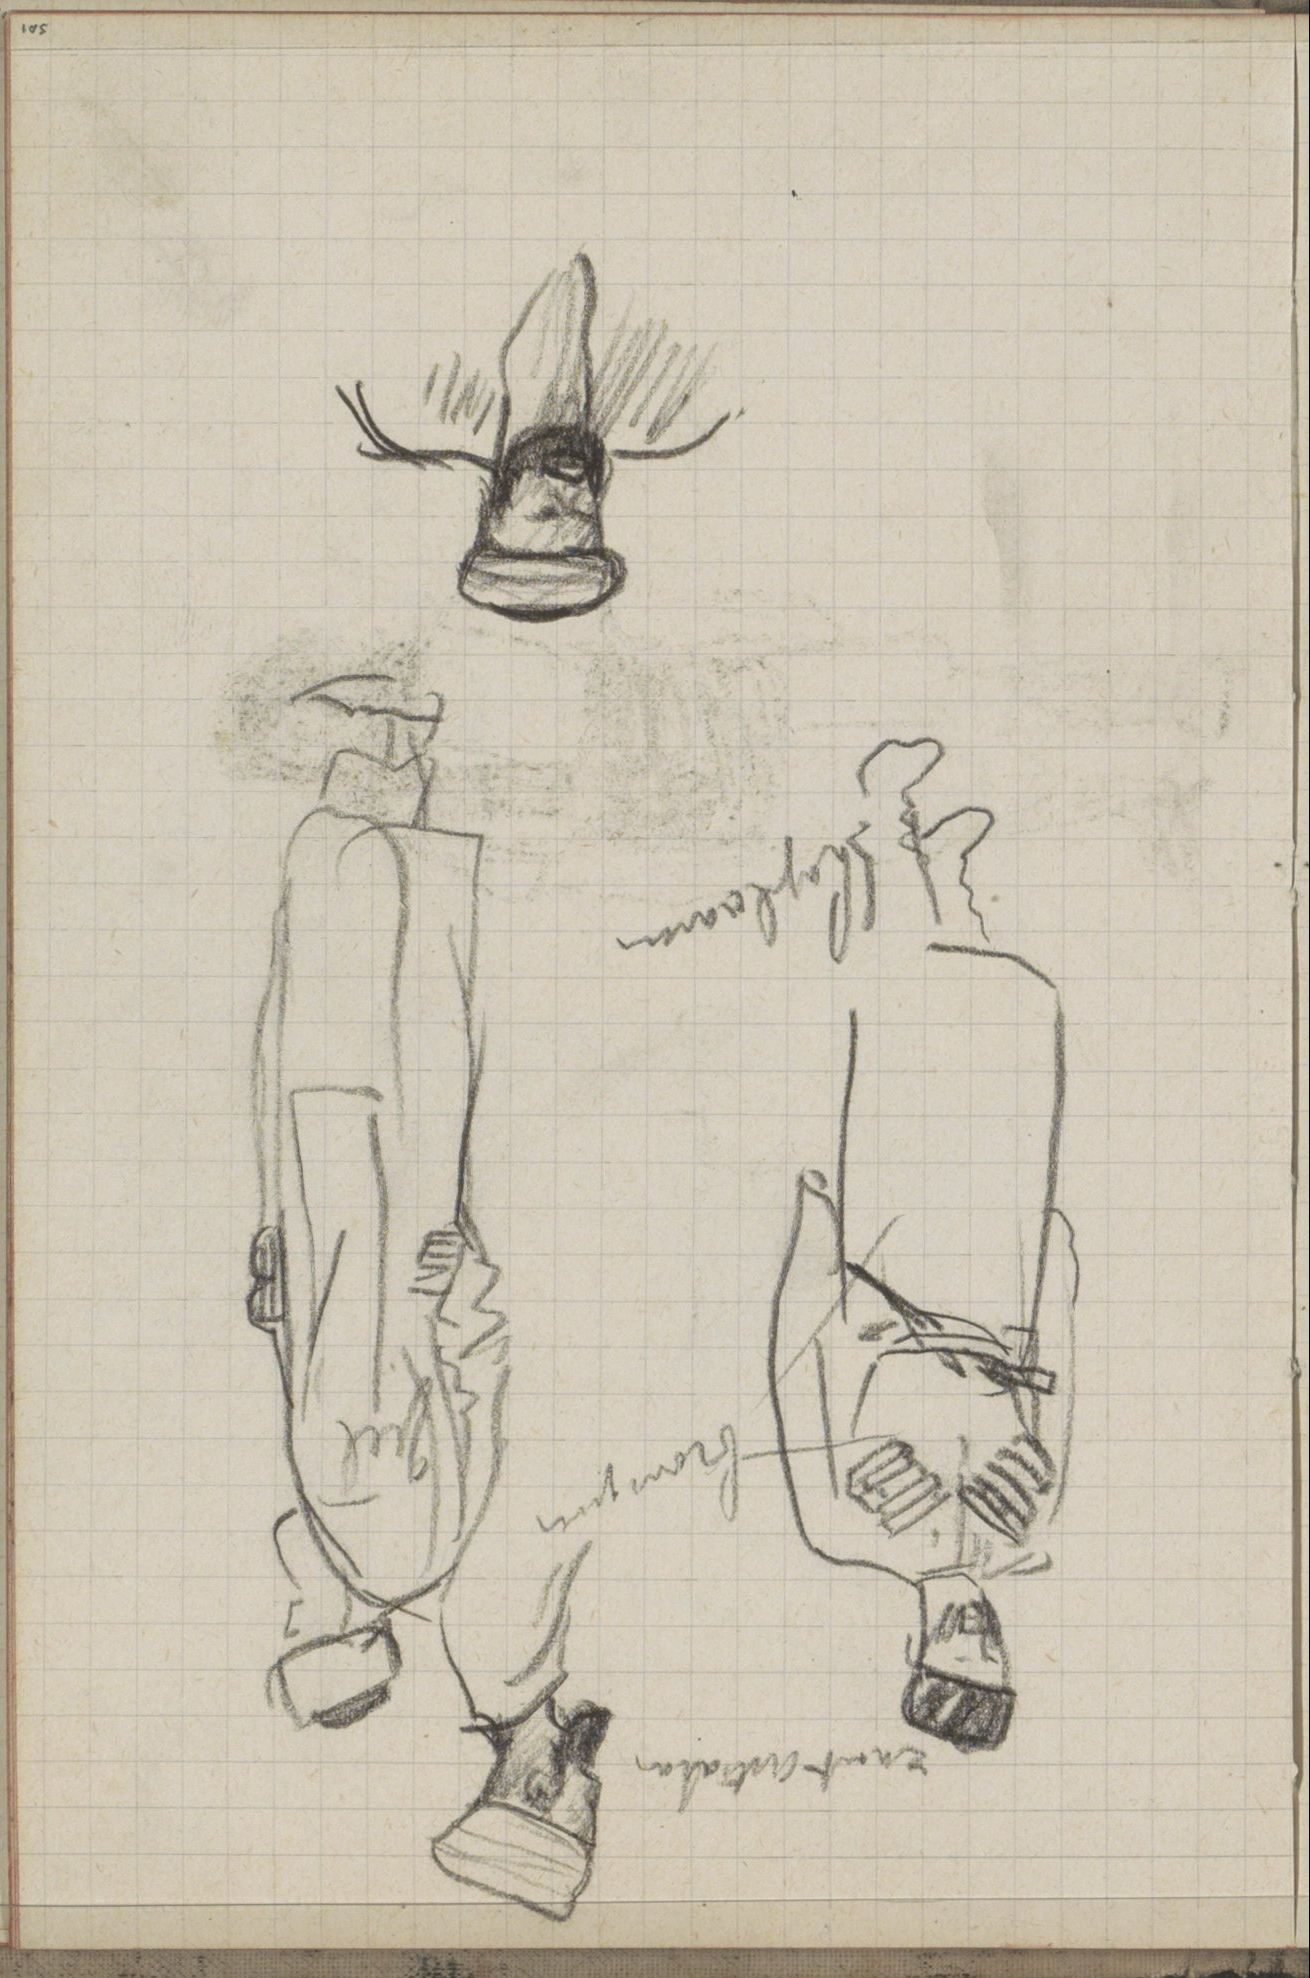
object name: sketchbook leaf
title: Mannen in oosterse kleding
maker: marius bauer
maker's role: draughtsman, print maker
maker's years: 1867-1932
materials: chalk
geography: istanbul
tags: asiatic races and peoples, head (human), standing figure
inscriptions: kleurnotitie, handgeschreven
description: Twee figuren ten voeten uit en twee koppen van verschillende aanzichten gezien. Pagina 105 uit een schetsboek met 54 bladen.